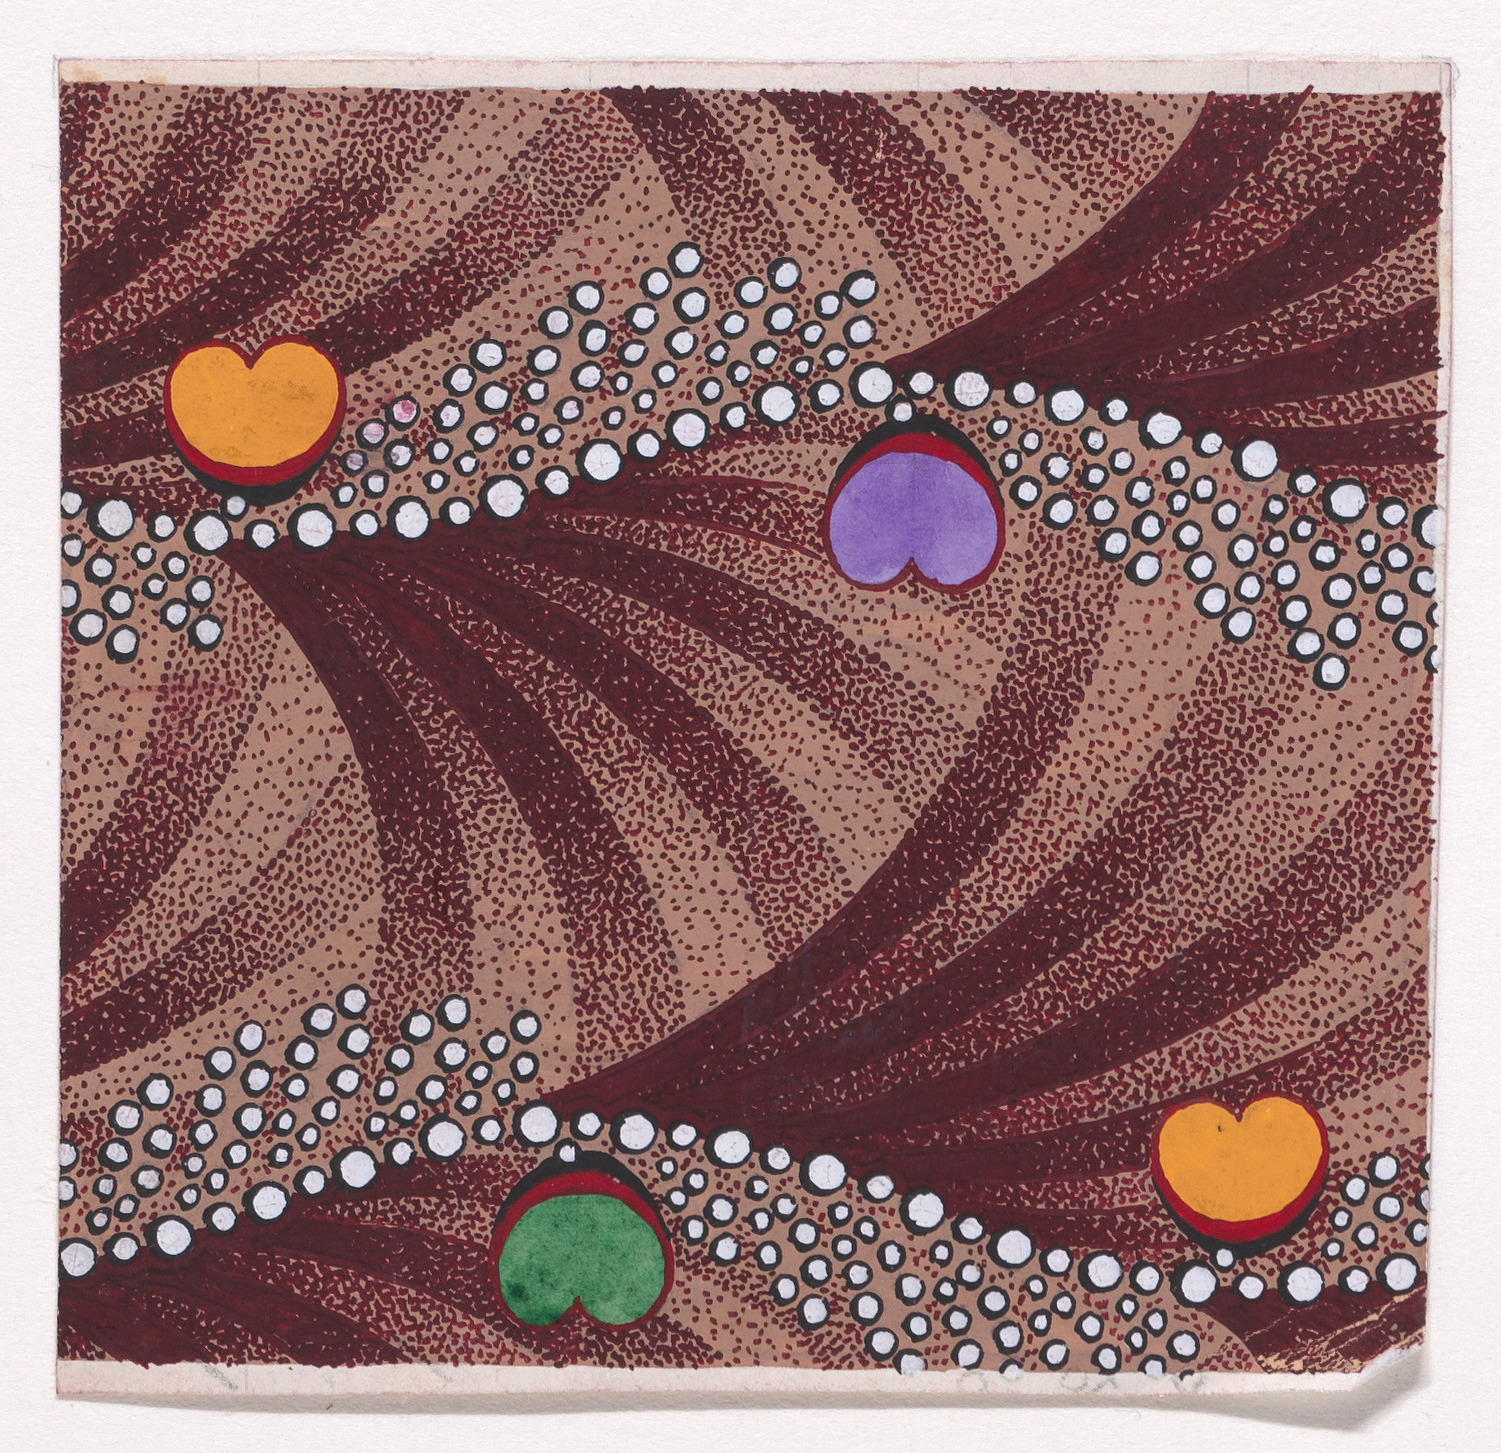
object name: drawing ornament architecture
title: Textile Design with Horizontal Undulating Strips of Pearls with Alternating Offsetting Bundles of Pearls and Heart Shapes over a Background of Alternating Overlapping Scales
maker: anonymous, alsatian, 19th century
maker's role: artist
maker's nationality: alsatian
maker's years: 1800-1900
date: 1840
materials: gouache